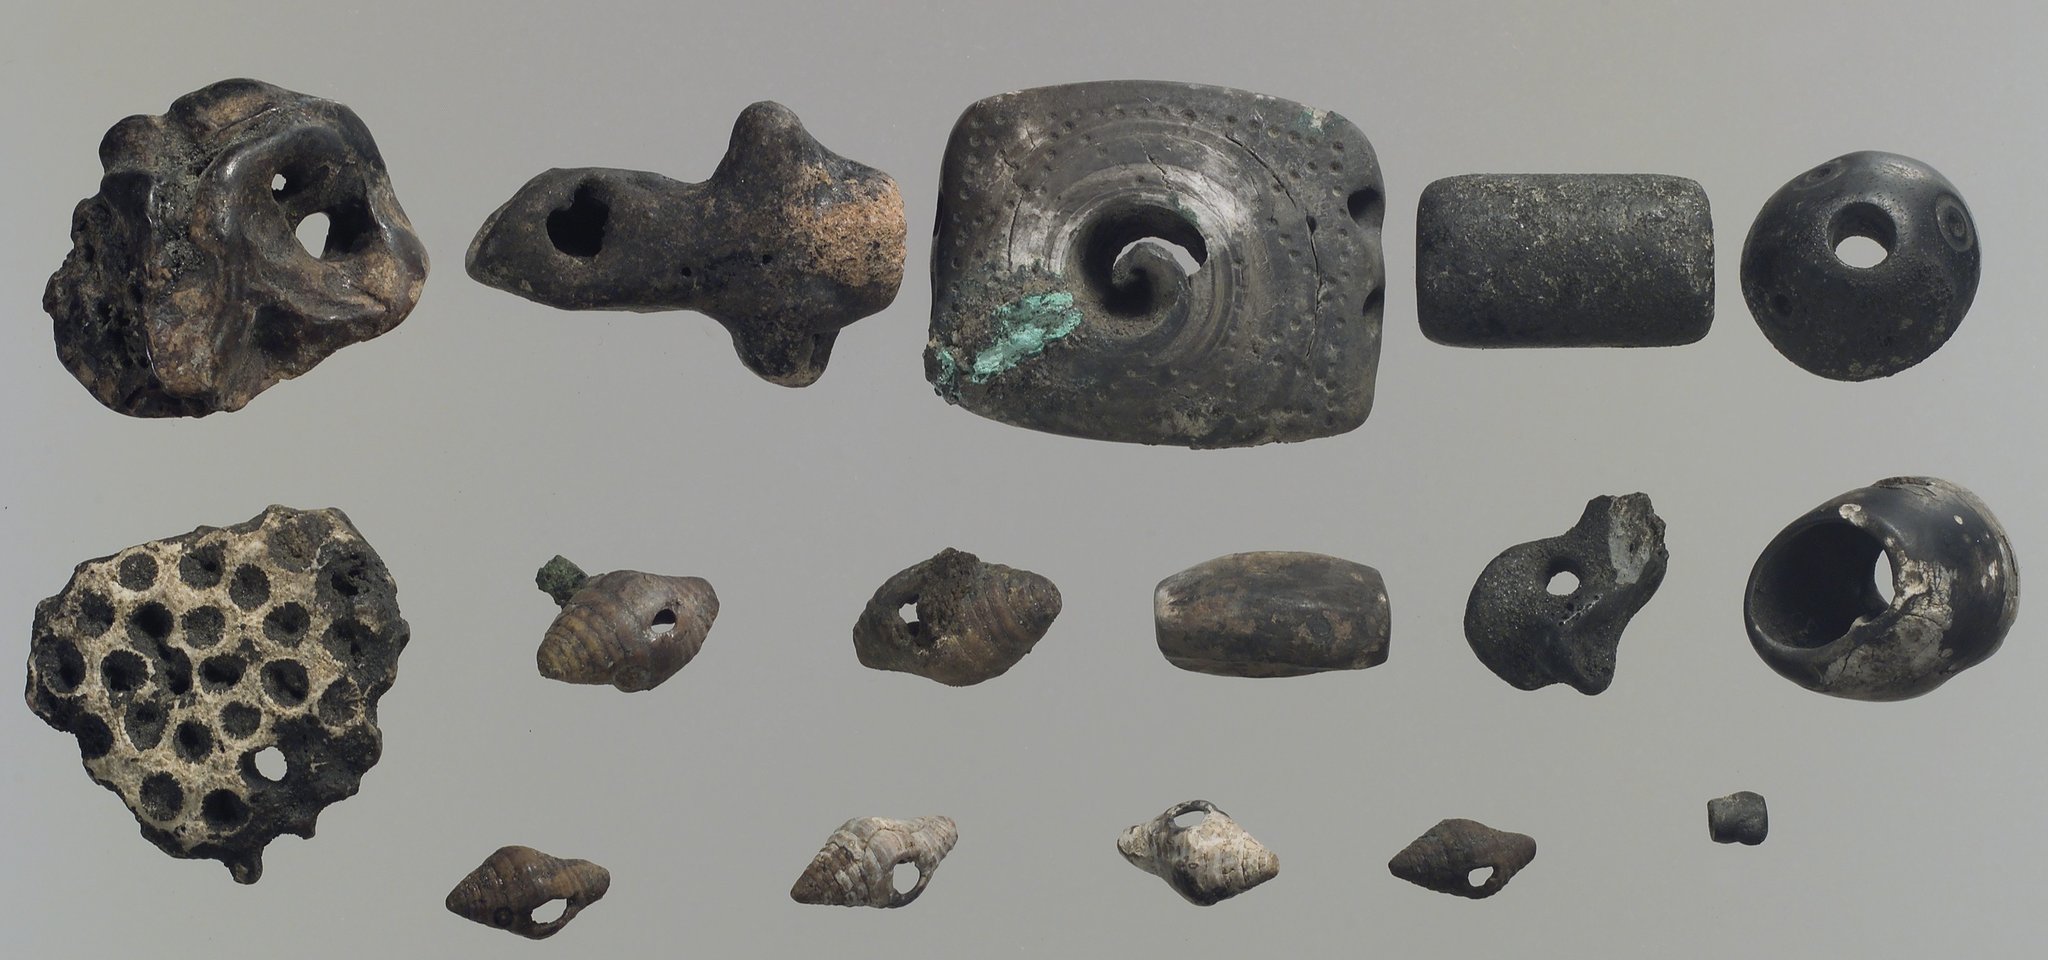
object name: bead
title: Beads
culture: iranian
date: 900-801 BCE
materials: bone, coral, shell, stone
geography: iran